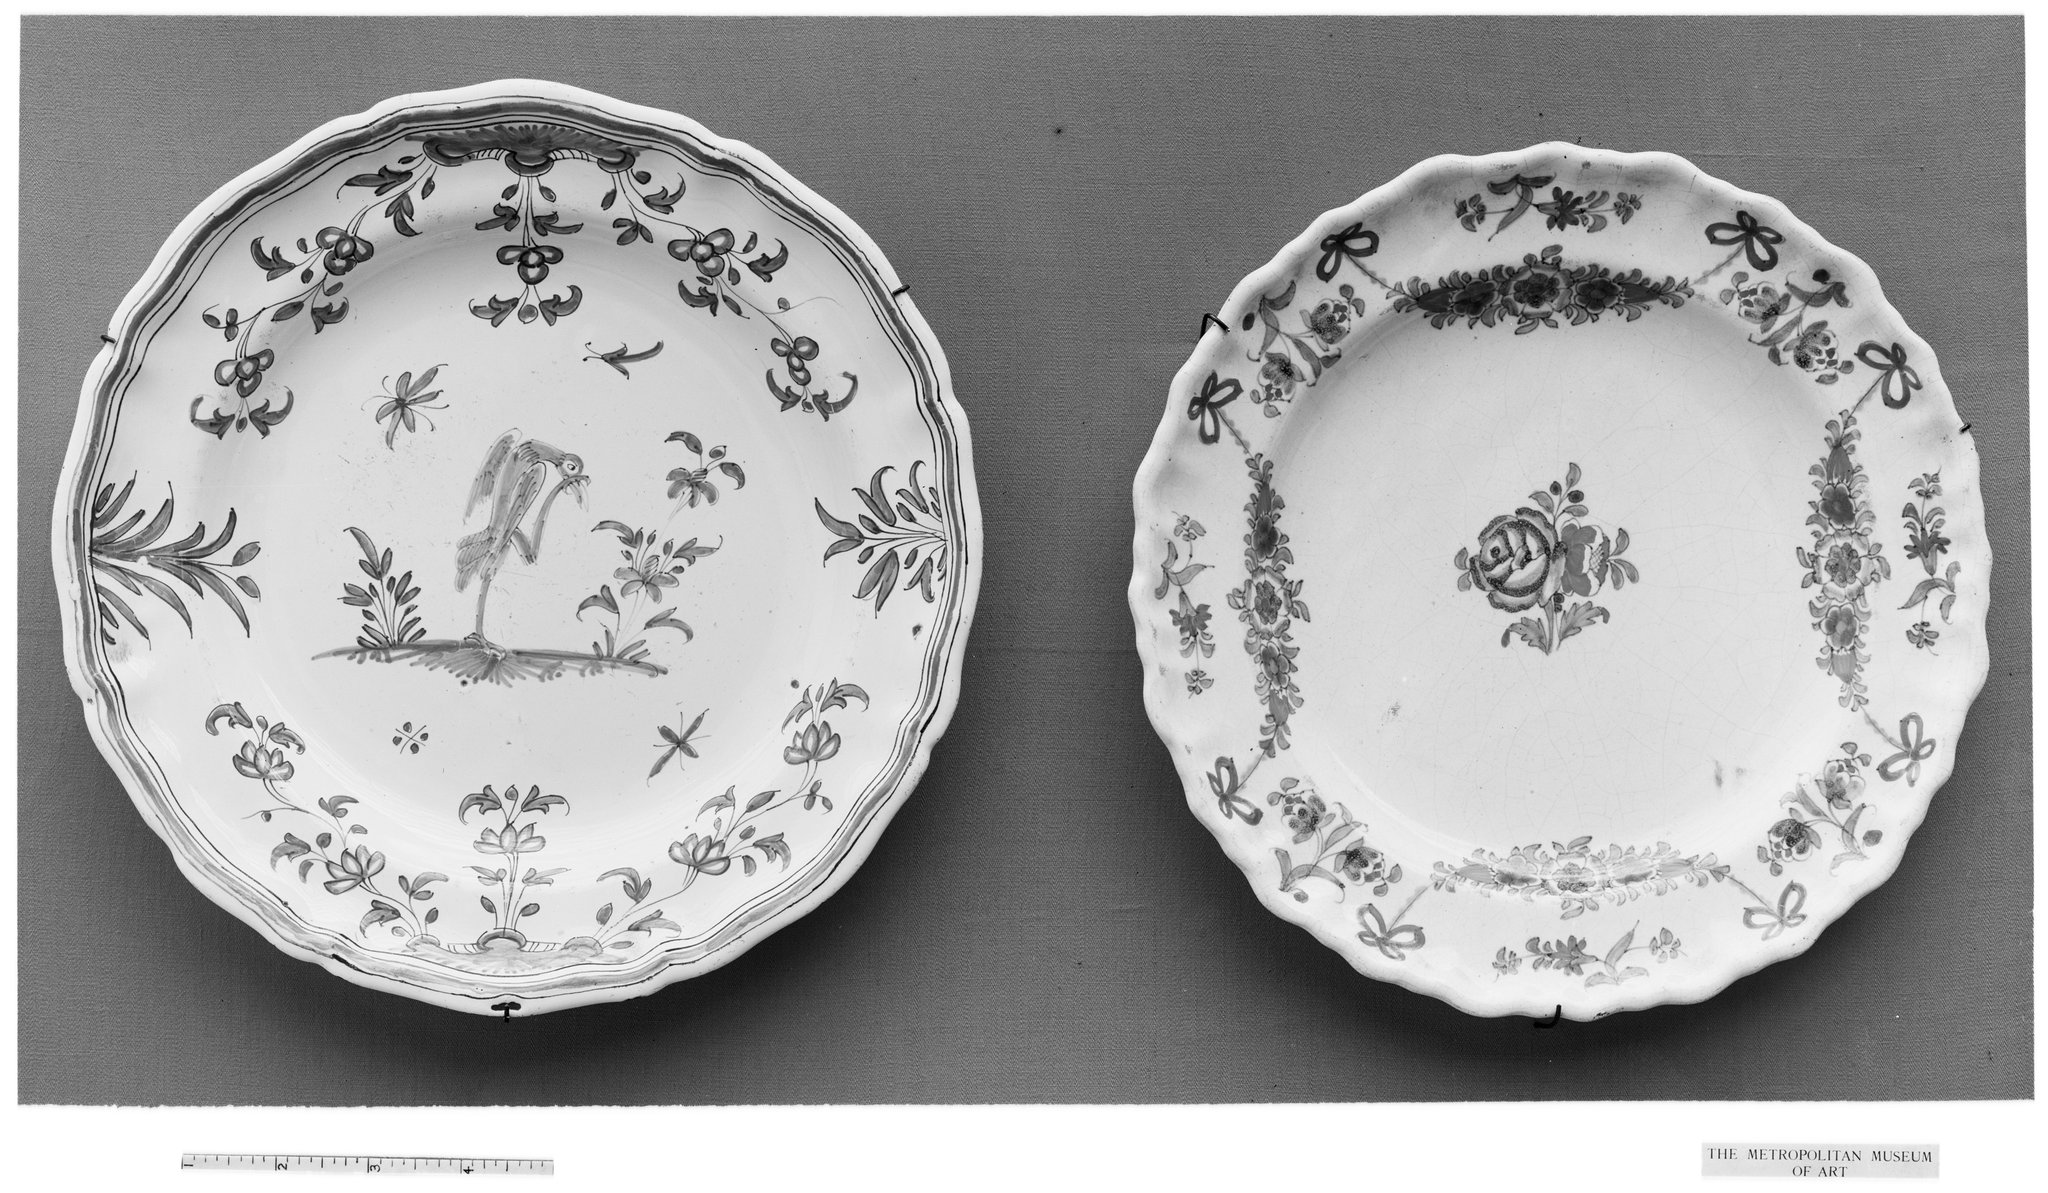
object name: plate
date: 1701-1800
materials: faience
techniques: glazing